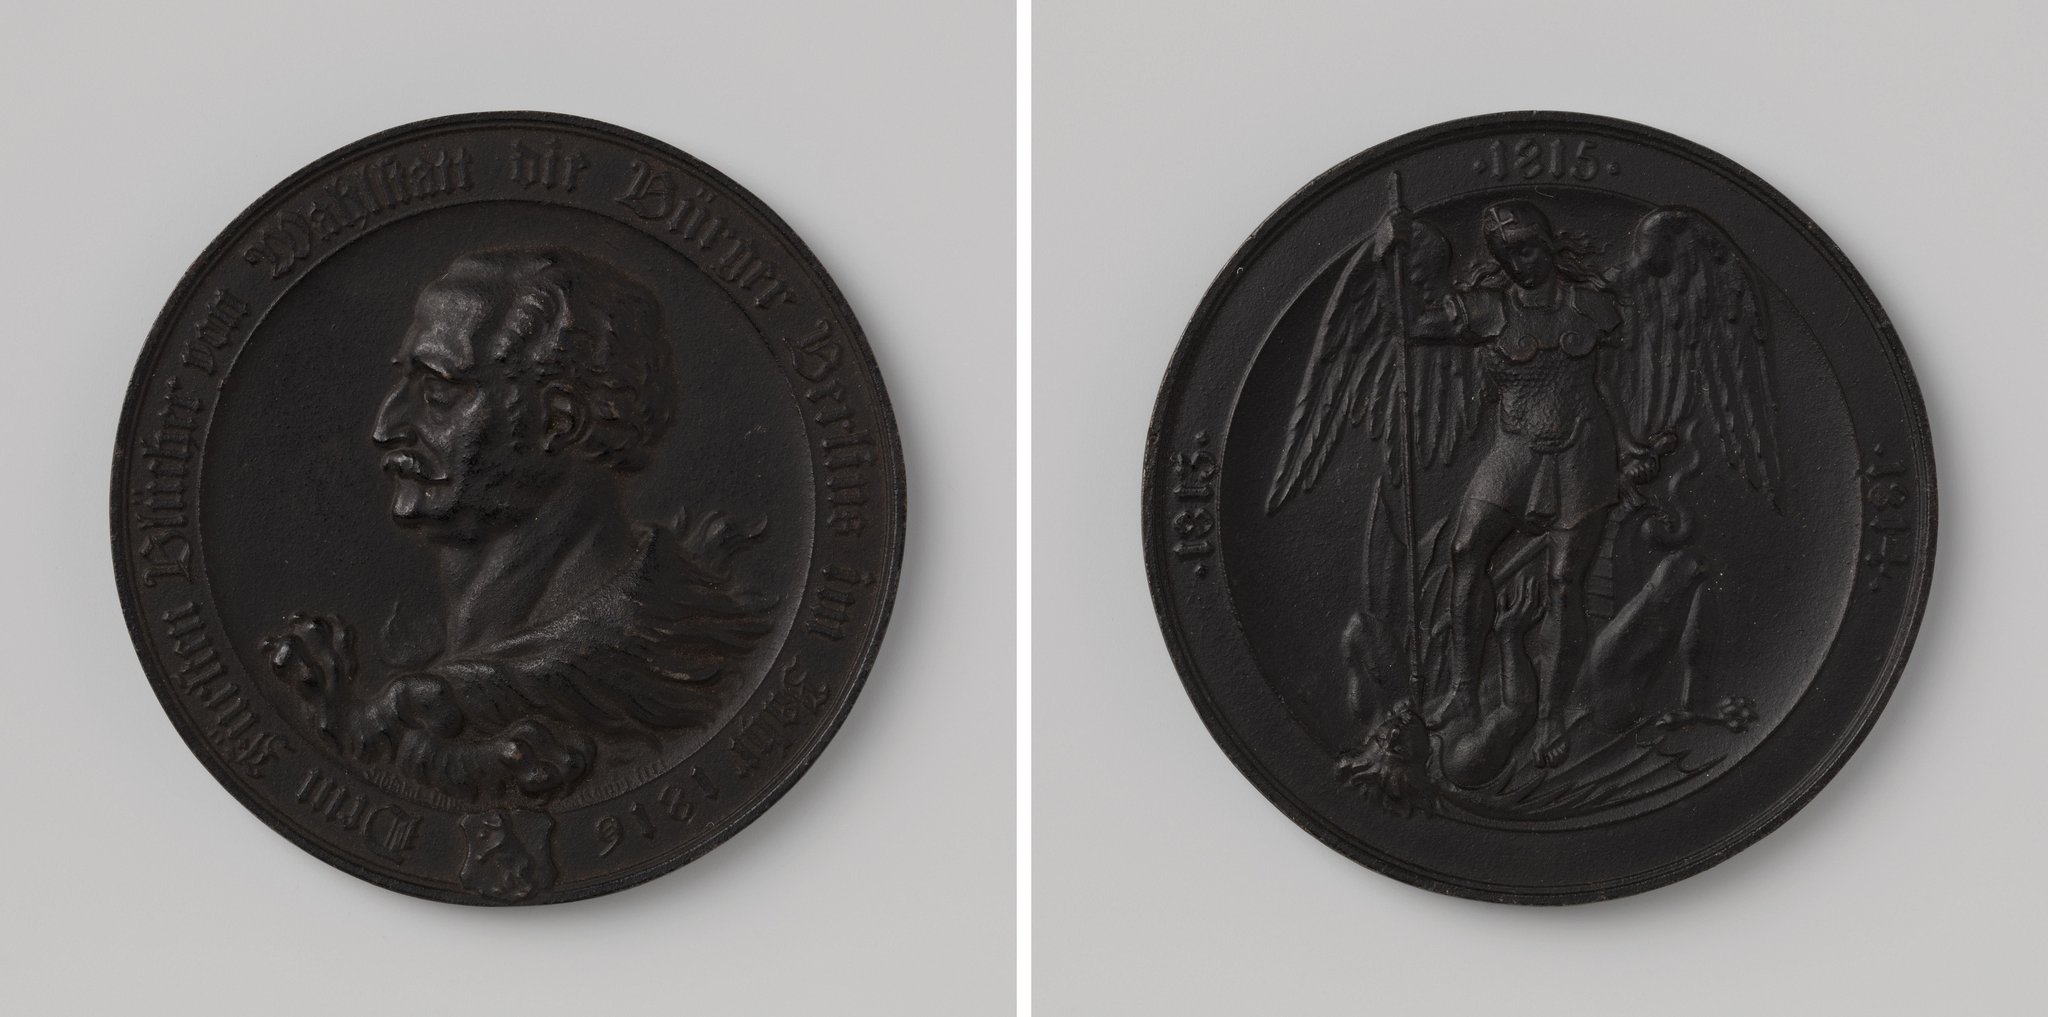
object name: plaque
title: Gebhard Leberecht, vorst Blucher von Wahlstatt, penning door de burgers van Berlijn vereerd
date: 1816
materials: iron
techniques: striking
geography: berlin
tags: rostock, generaal, gebhard leberecht von blücher von wahlstatt, napoleontische oorlogen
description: Voorzijde: borststuk man met leeuwehuid binnen omschrift in Gothisch schrift, onderbroken door wapenschild. Keerzijde: gevleugelde aartsengel Michael, met helm met kruis op hoofd, staat op punt ter aarde liggend monster met mensenhoofd met zijn speer te doorboren binnen omschrift